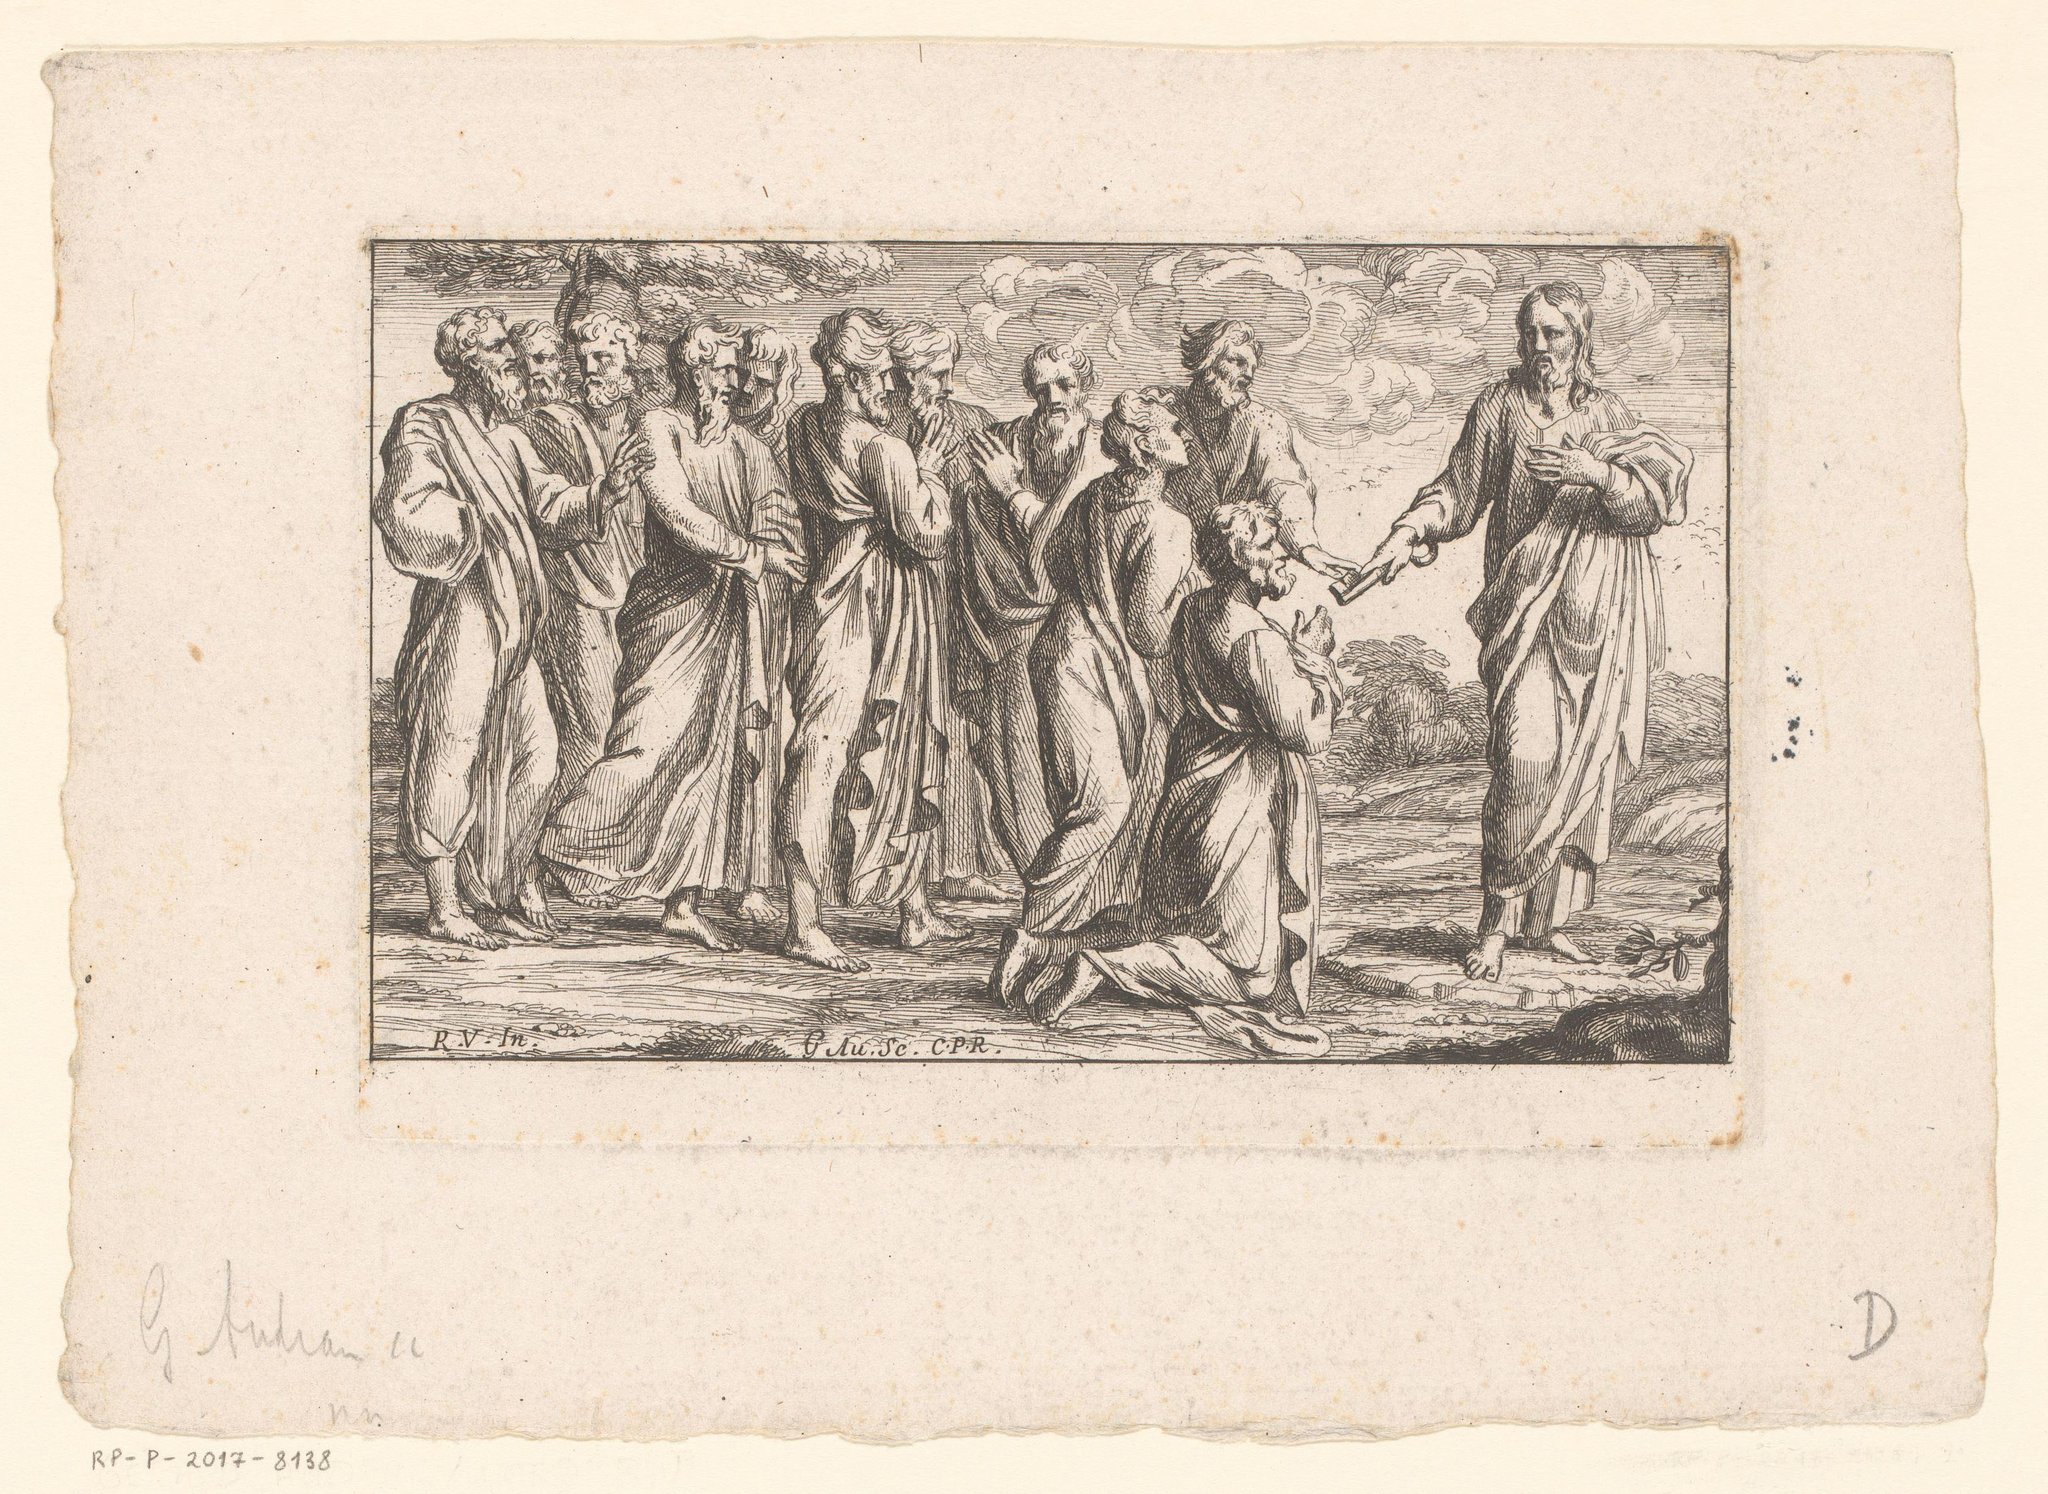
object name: print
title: Petrus ontvangt de sleutels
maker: gérard audran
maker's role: print maker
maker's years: 1640-1703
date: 1650-1703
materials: paper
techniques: etching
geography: france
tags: christ gives the keys of heaven to peter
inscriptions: collector's mark: Lugt 2228